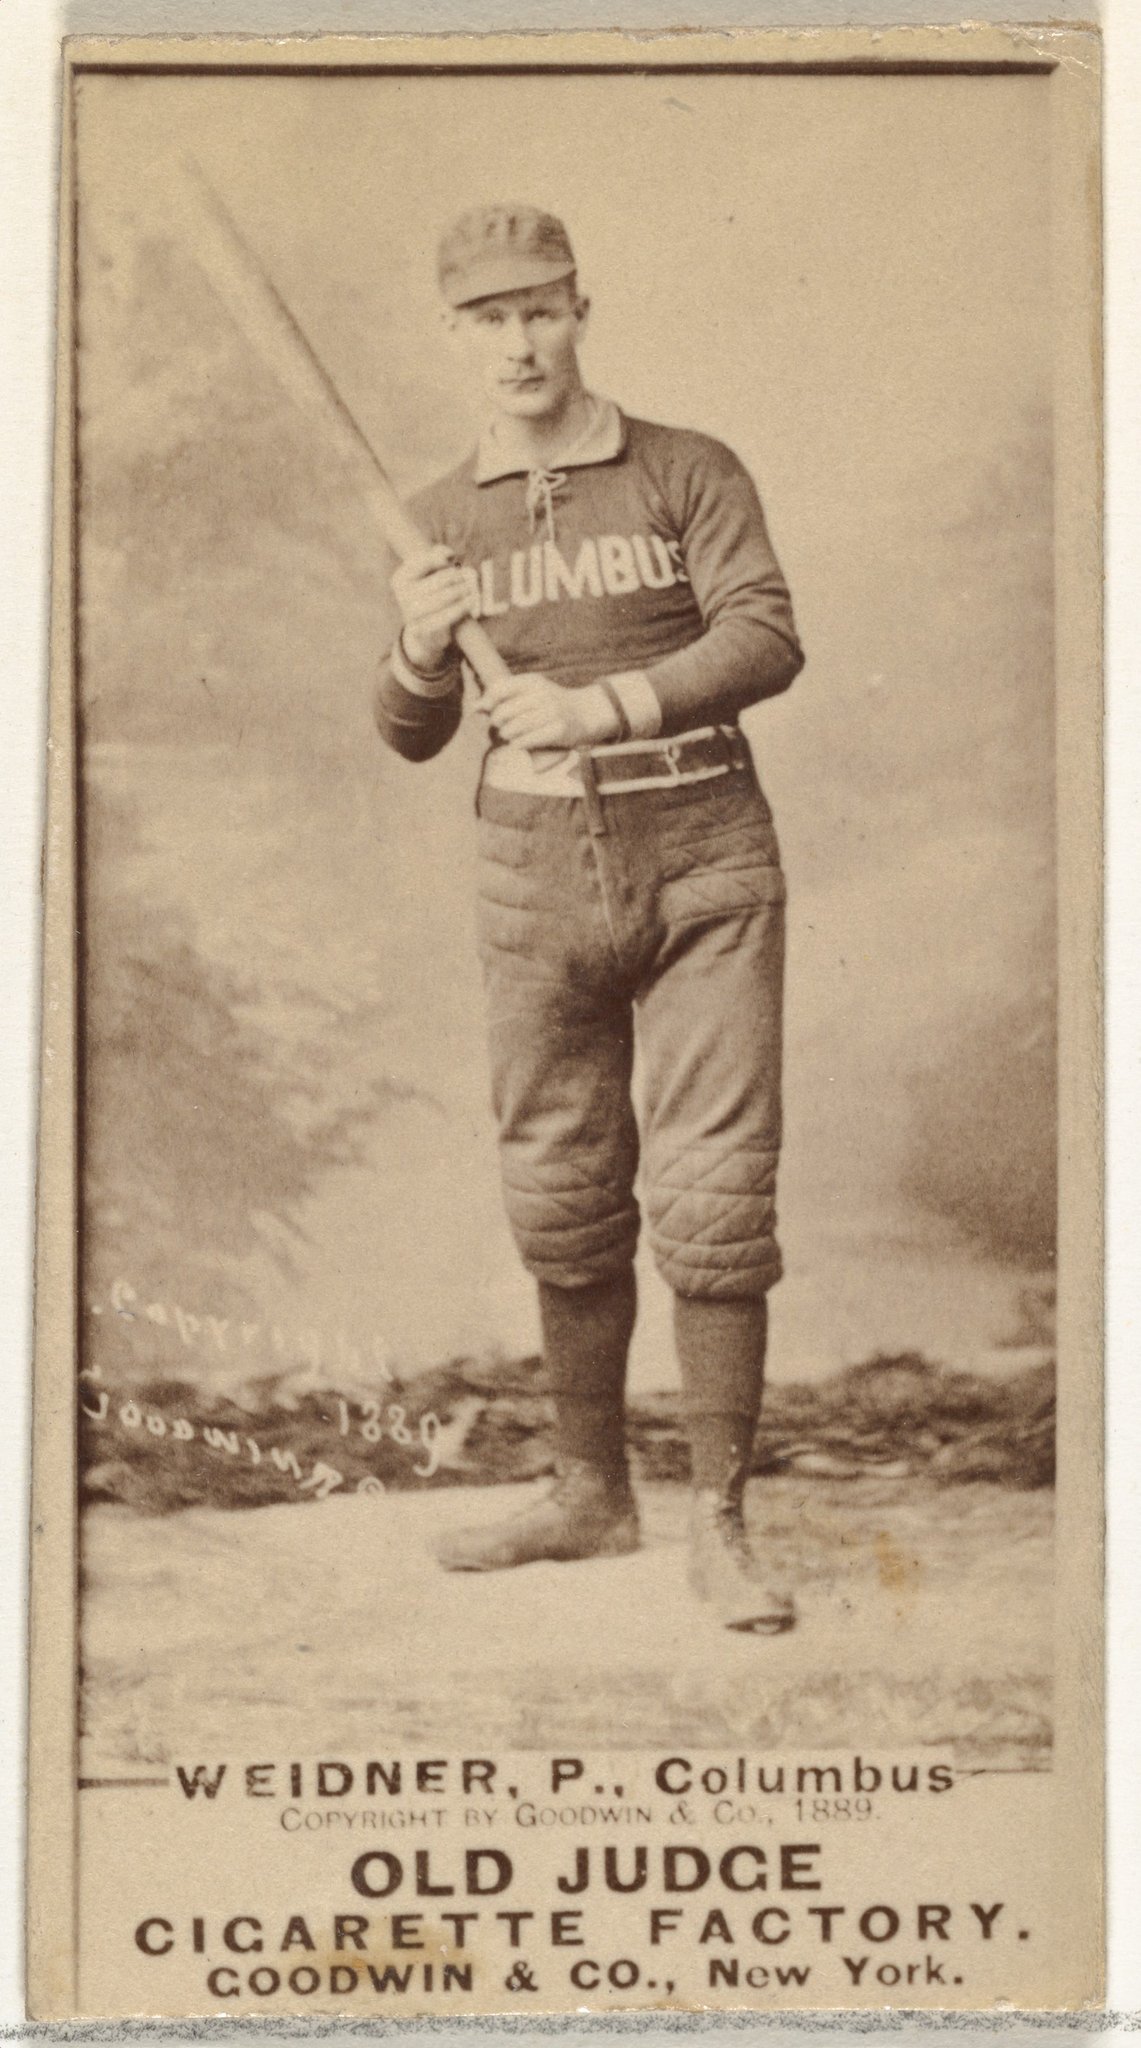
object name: baseball card, photograph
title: William Waterfield "Wild Bill" Widner, Pitcher, Cleveland, from the Old Judge series (N172) for Old Judge Cigarettes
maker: goodwin & company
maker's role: publisher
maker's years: 1850-1950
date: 1889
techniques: albumen silver print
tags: men,portraits,baseball,athletes